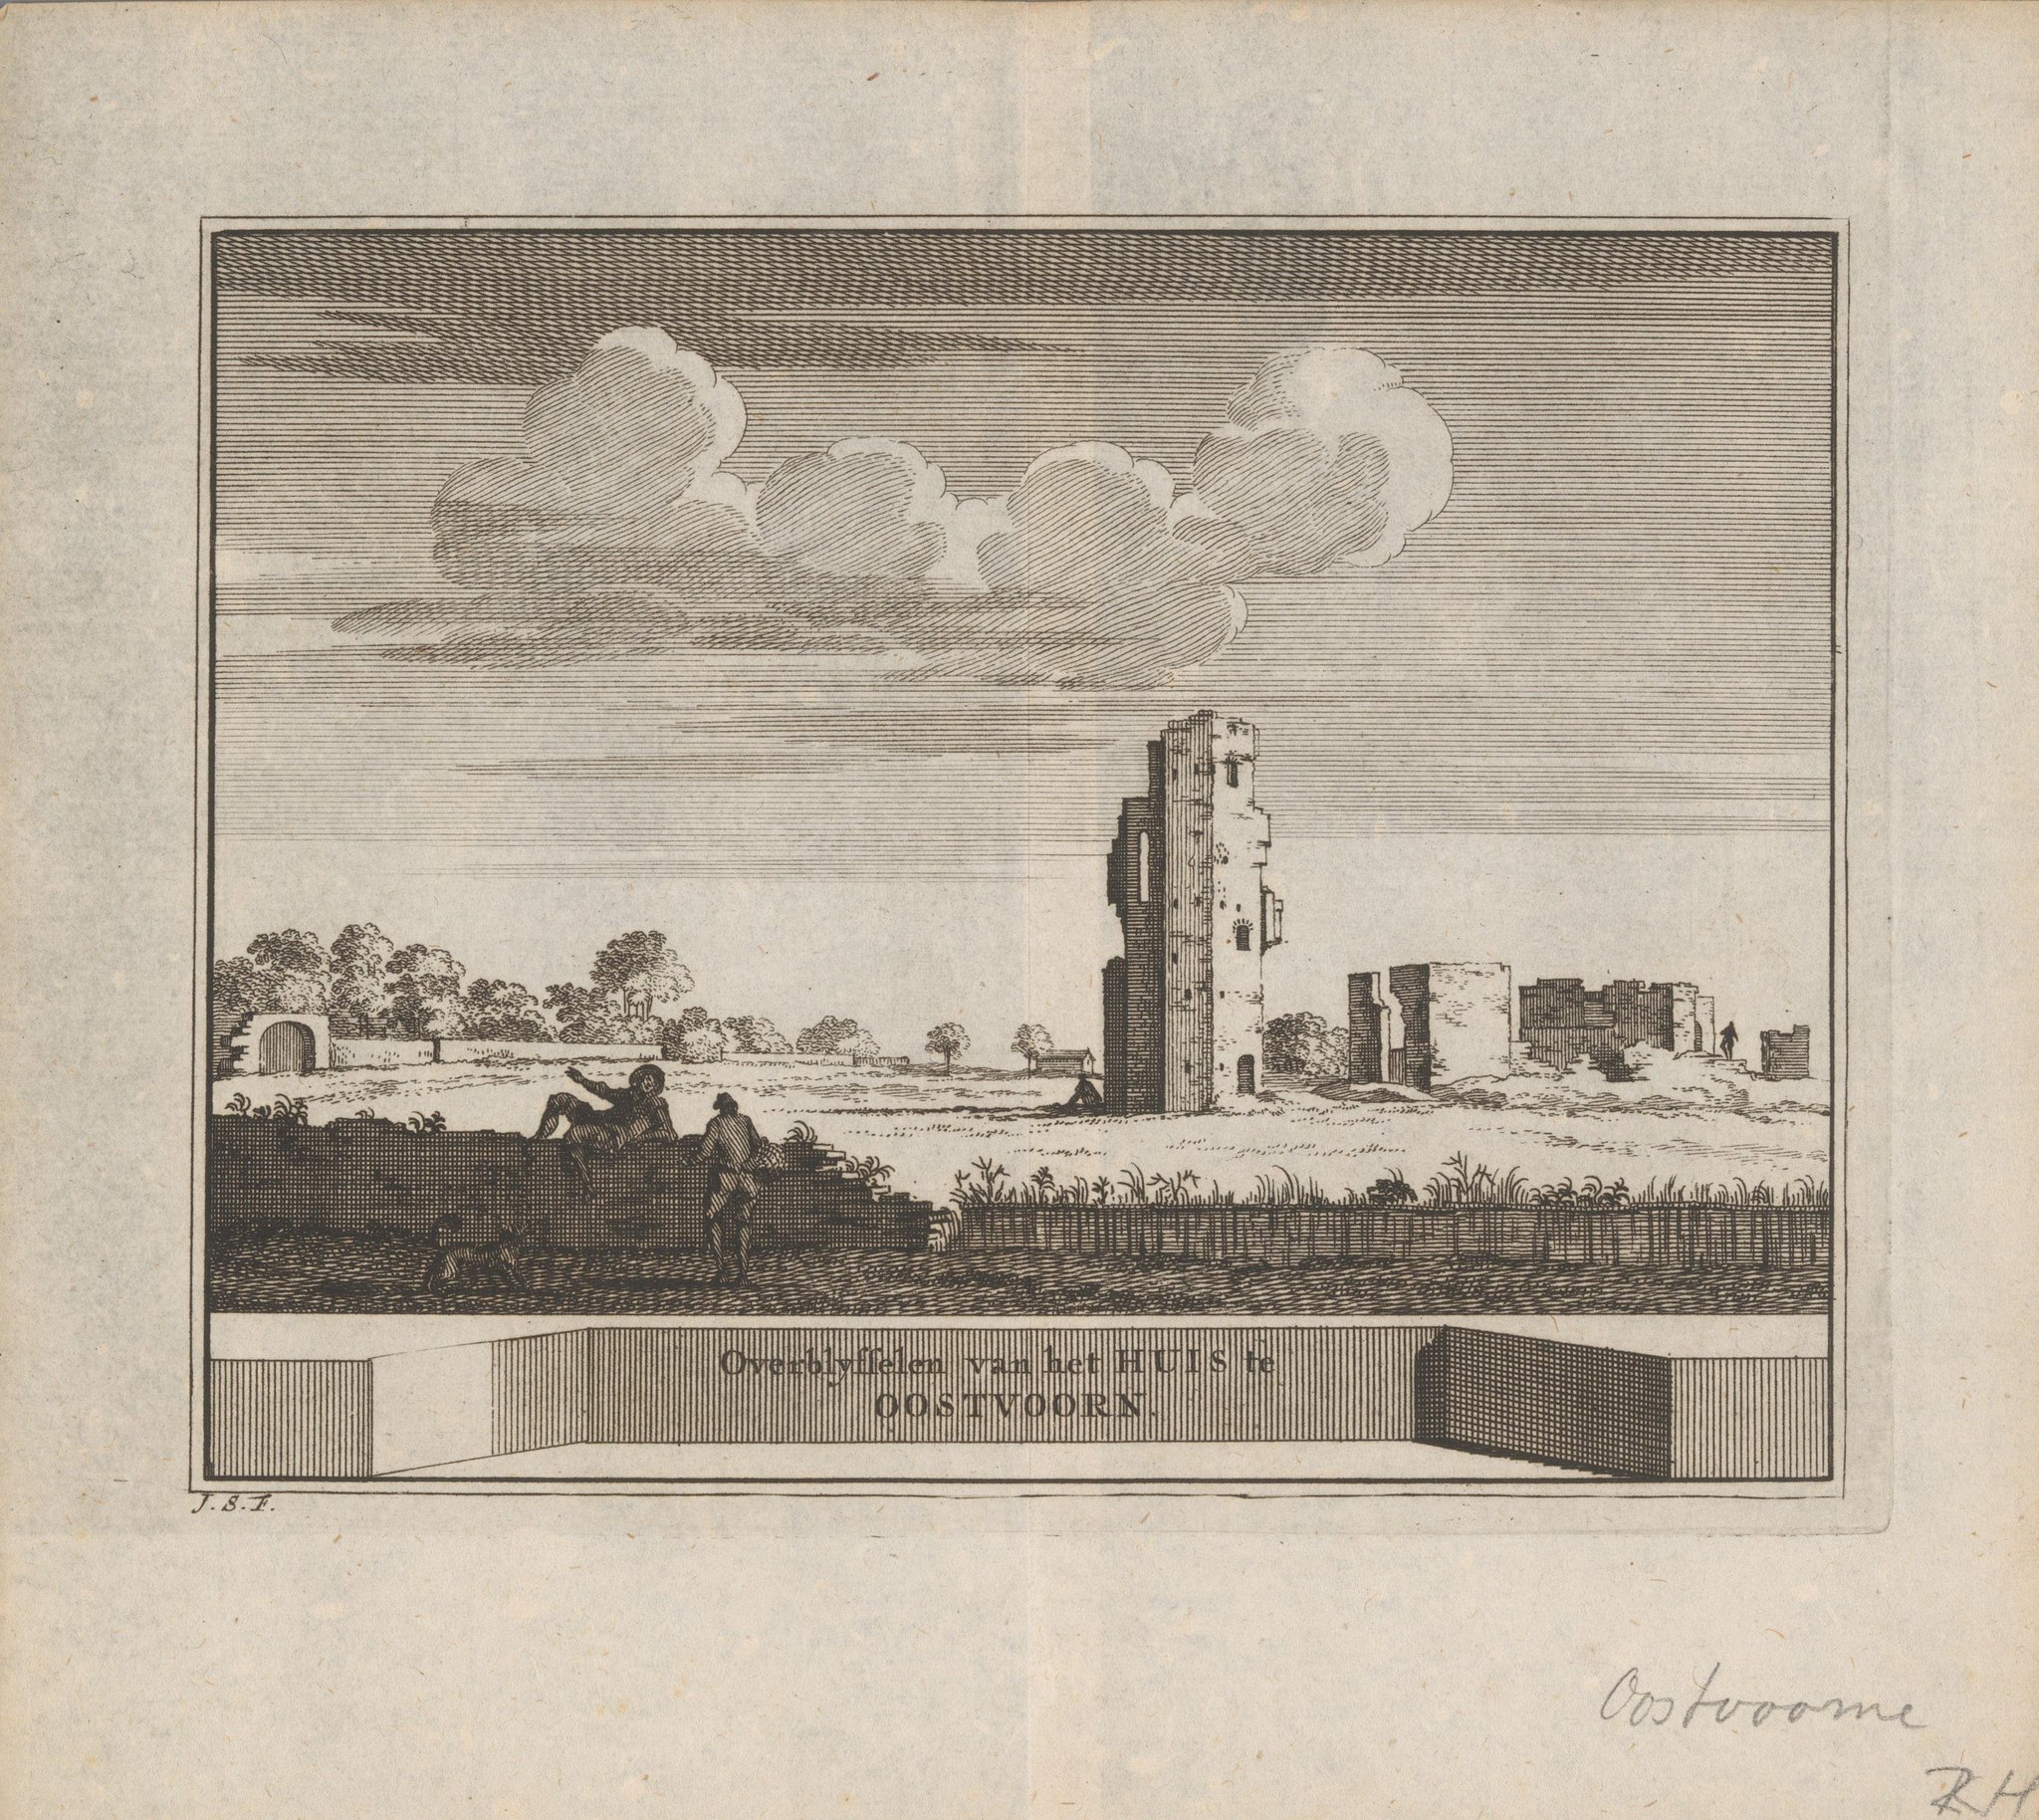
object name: book illustration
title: Gezicht op de ruïne van de Burcht van Voorne in Oostvoorne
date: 1711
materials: paper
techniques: engraving, etching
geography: amsterdam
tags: landscape with ruins, ruin of a dwelling, house, castle, etc., oostvoorne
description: Prent uit: Smids, Ludolf. Schatkamer der Nederlandsse oudheden (...). Amsterdam: Pieter de Coup, 1711, p. 256-257.